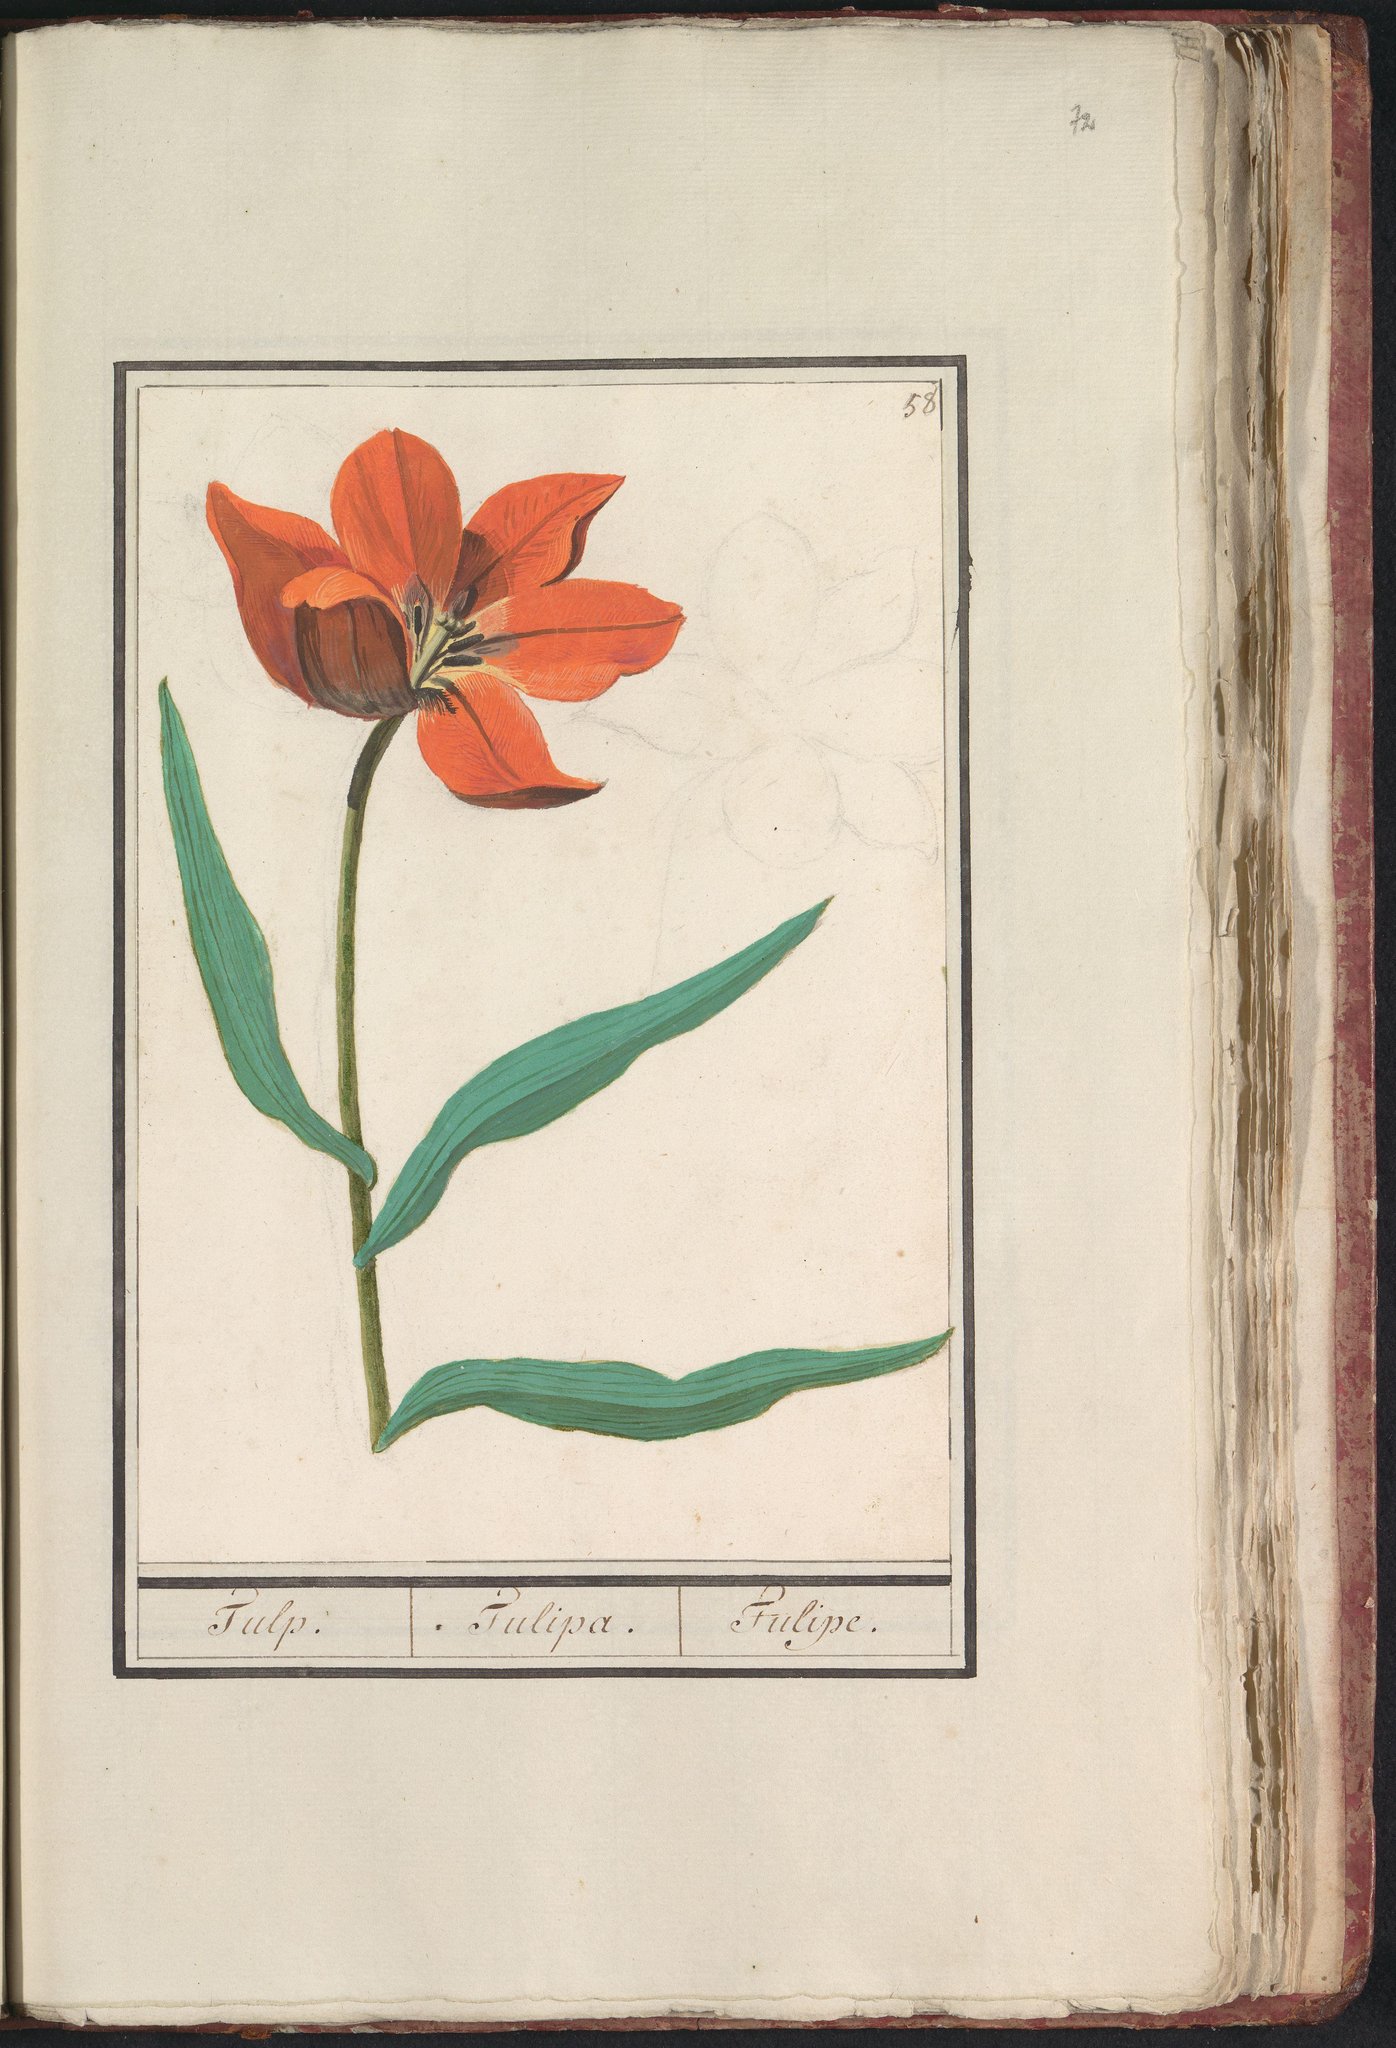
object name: drawing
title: Tulp. / Tulipa. / Tulipe.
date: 1596-1610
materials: chalk, paint, paper, watercolor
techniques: brush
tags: flowers: tulip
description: Oranje tulp. Genummerd rechtsboven: 58. Onderdeel van het eerste album met tekeningen van bloemen en planten. Achtste van twaalf albums met tekeningen van dieren, vogels en planten bekend rond 1600, gemaakt in opdracht van keizer Rudolf II. Met toelichting in Nederlands, Latijn en Frans.